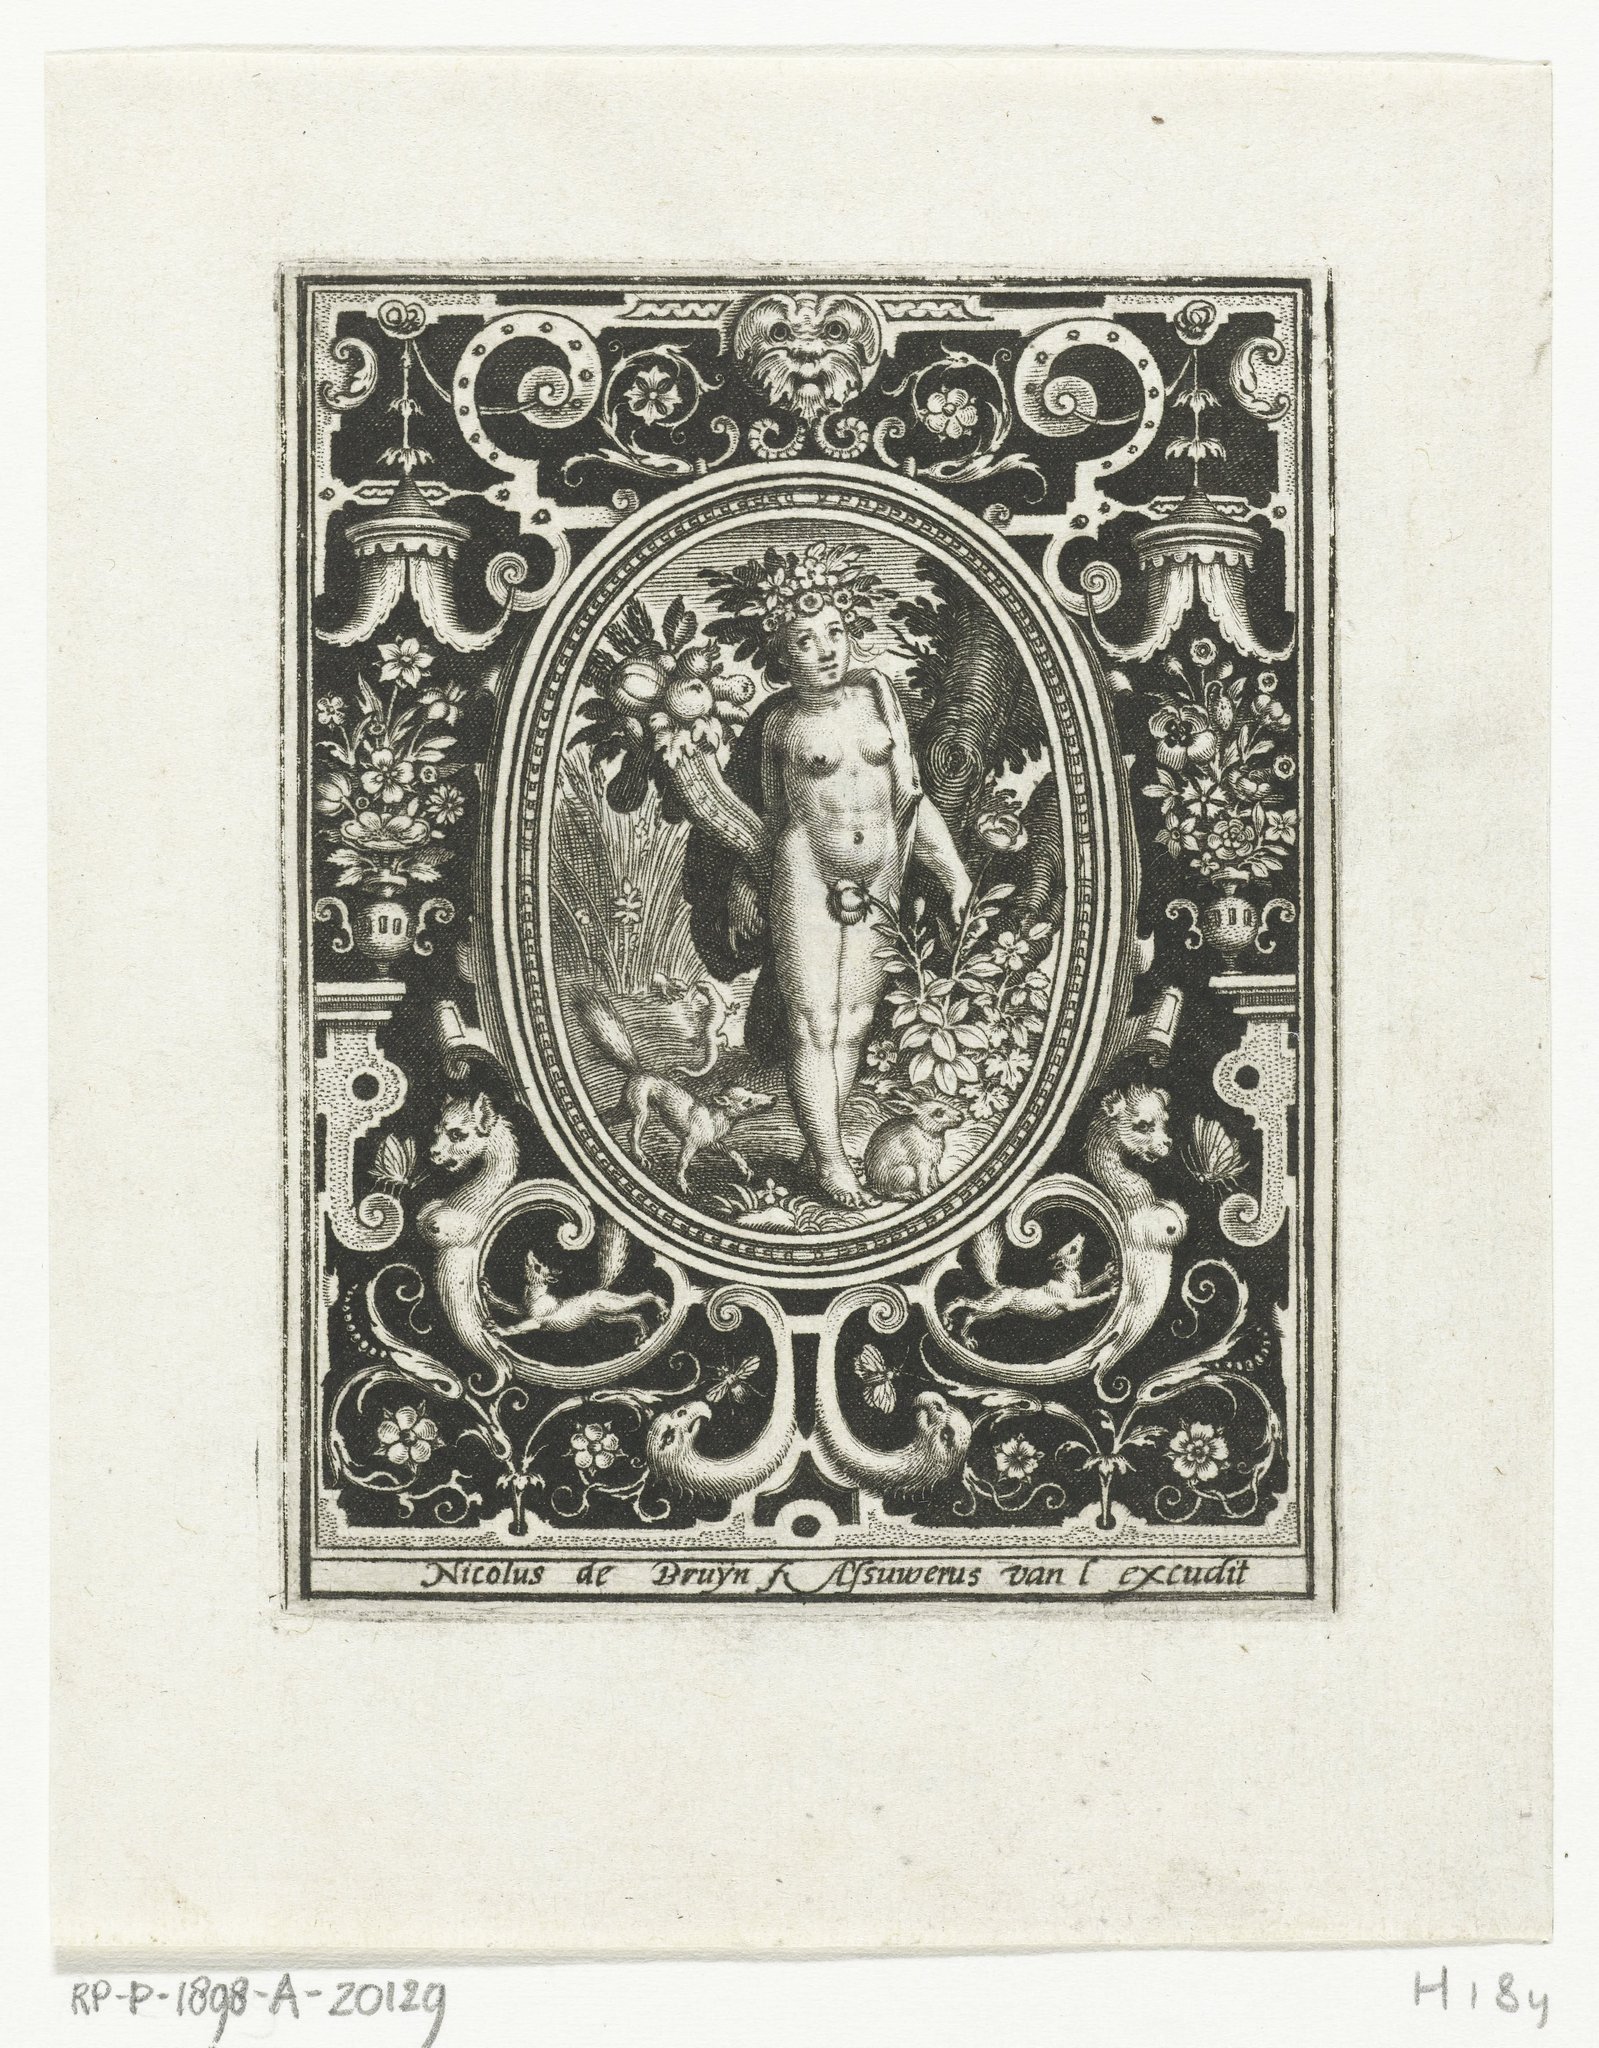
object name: print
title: Vier elementen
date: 1582-1635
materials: paper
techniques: engraving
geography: netherlands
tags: 'cornucopia', horn of plenty, earth (one of the four elements)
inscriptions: collector's mark: Lugt 2228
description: Prent uit serie van vier prenten met de vier elementen. De drukplaten zijn voor deze serie opnieuw gebruikt, vergelijk de serie van vier deugden waarbij de omlijsting met ornamenten identiek is (Hollstein nrs. 178-181). Het lijkt er op dat de platen voor de vier elementen werden opgewerkt want de donkere achtergrond is zwaarder geëtst.